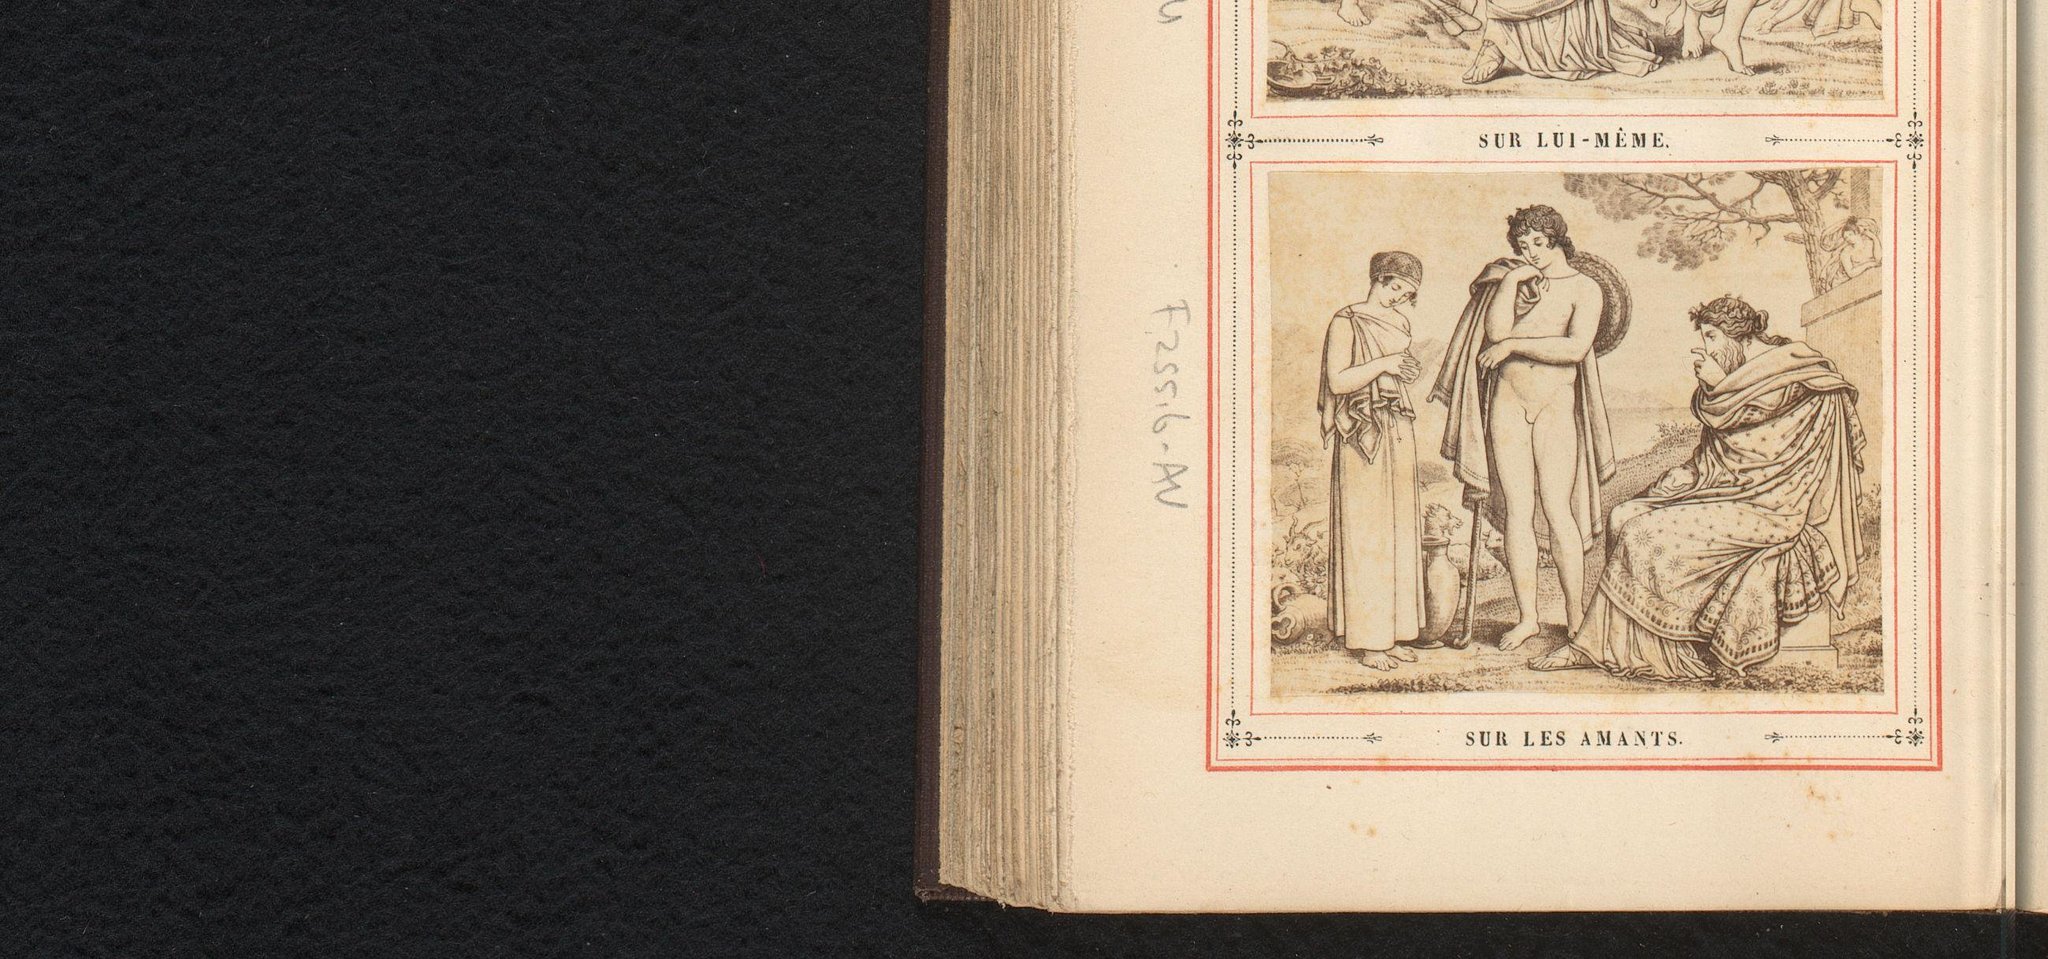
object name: page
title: Fotoreproductie van een tekening van Girodet, twee goden worden toegesproken, illustratie bij Apothéose d'Anacréon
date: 1859-1864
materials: paper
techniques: albumen print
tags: gods ~ classical mythology